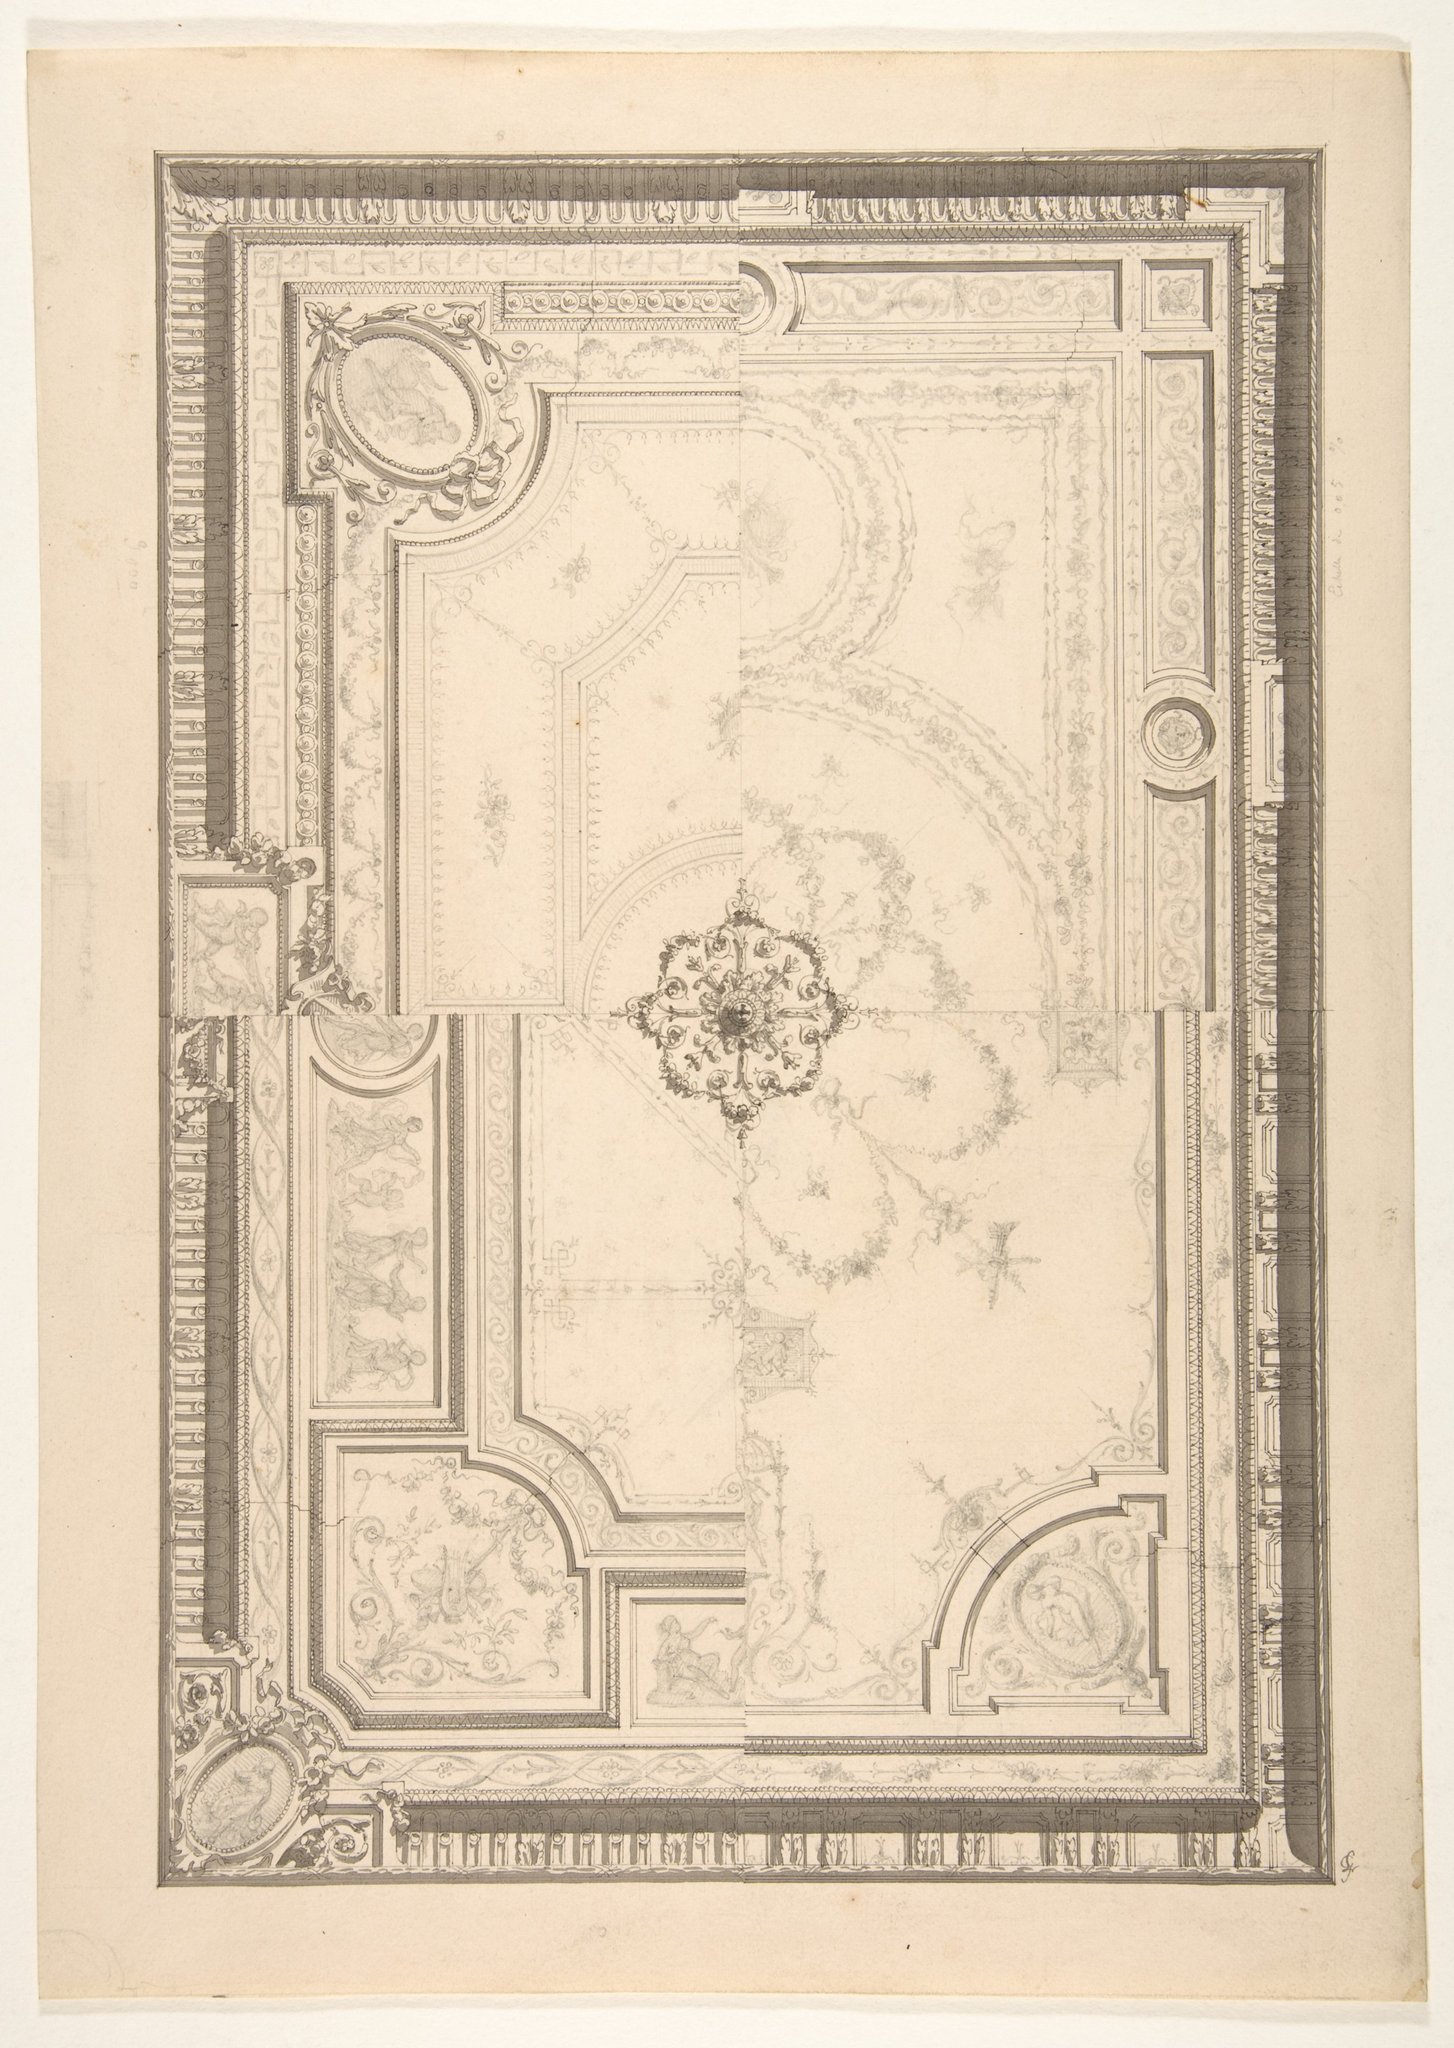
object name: drawing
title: Design for a ceiling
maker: jules-edmond-charles lachaise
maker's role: artist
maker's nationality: french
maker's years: 1897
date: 1851-1900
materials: graphite, ink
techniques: pen, wash